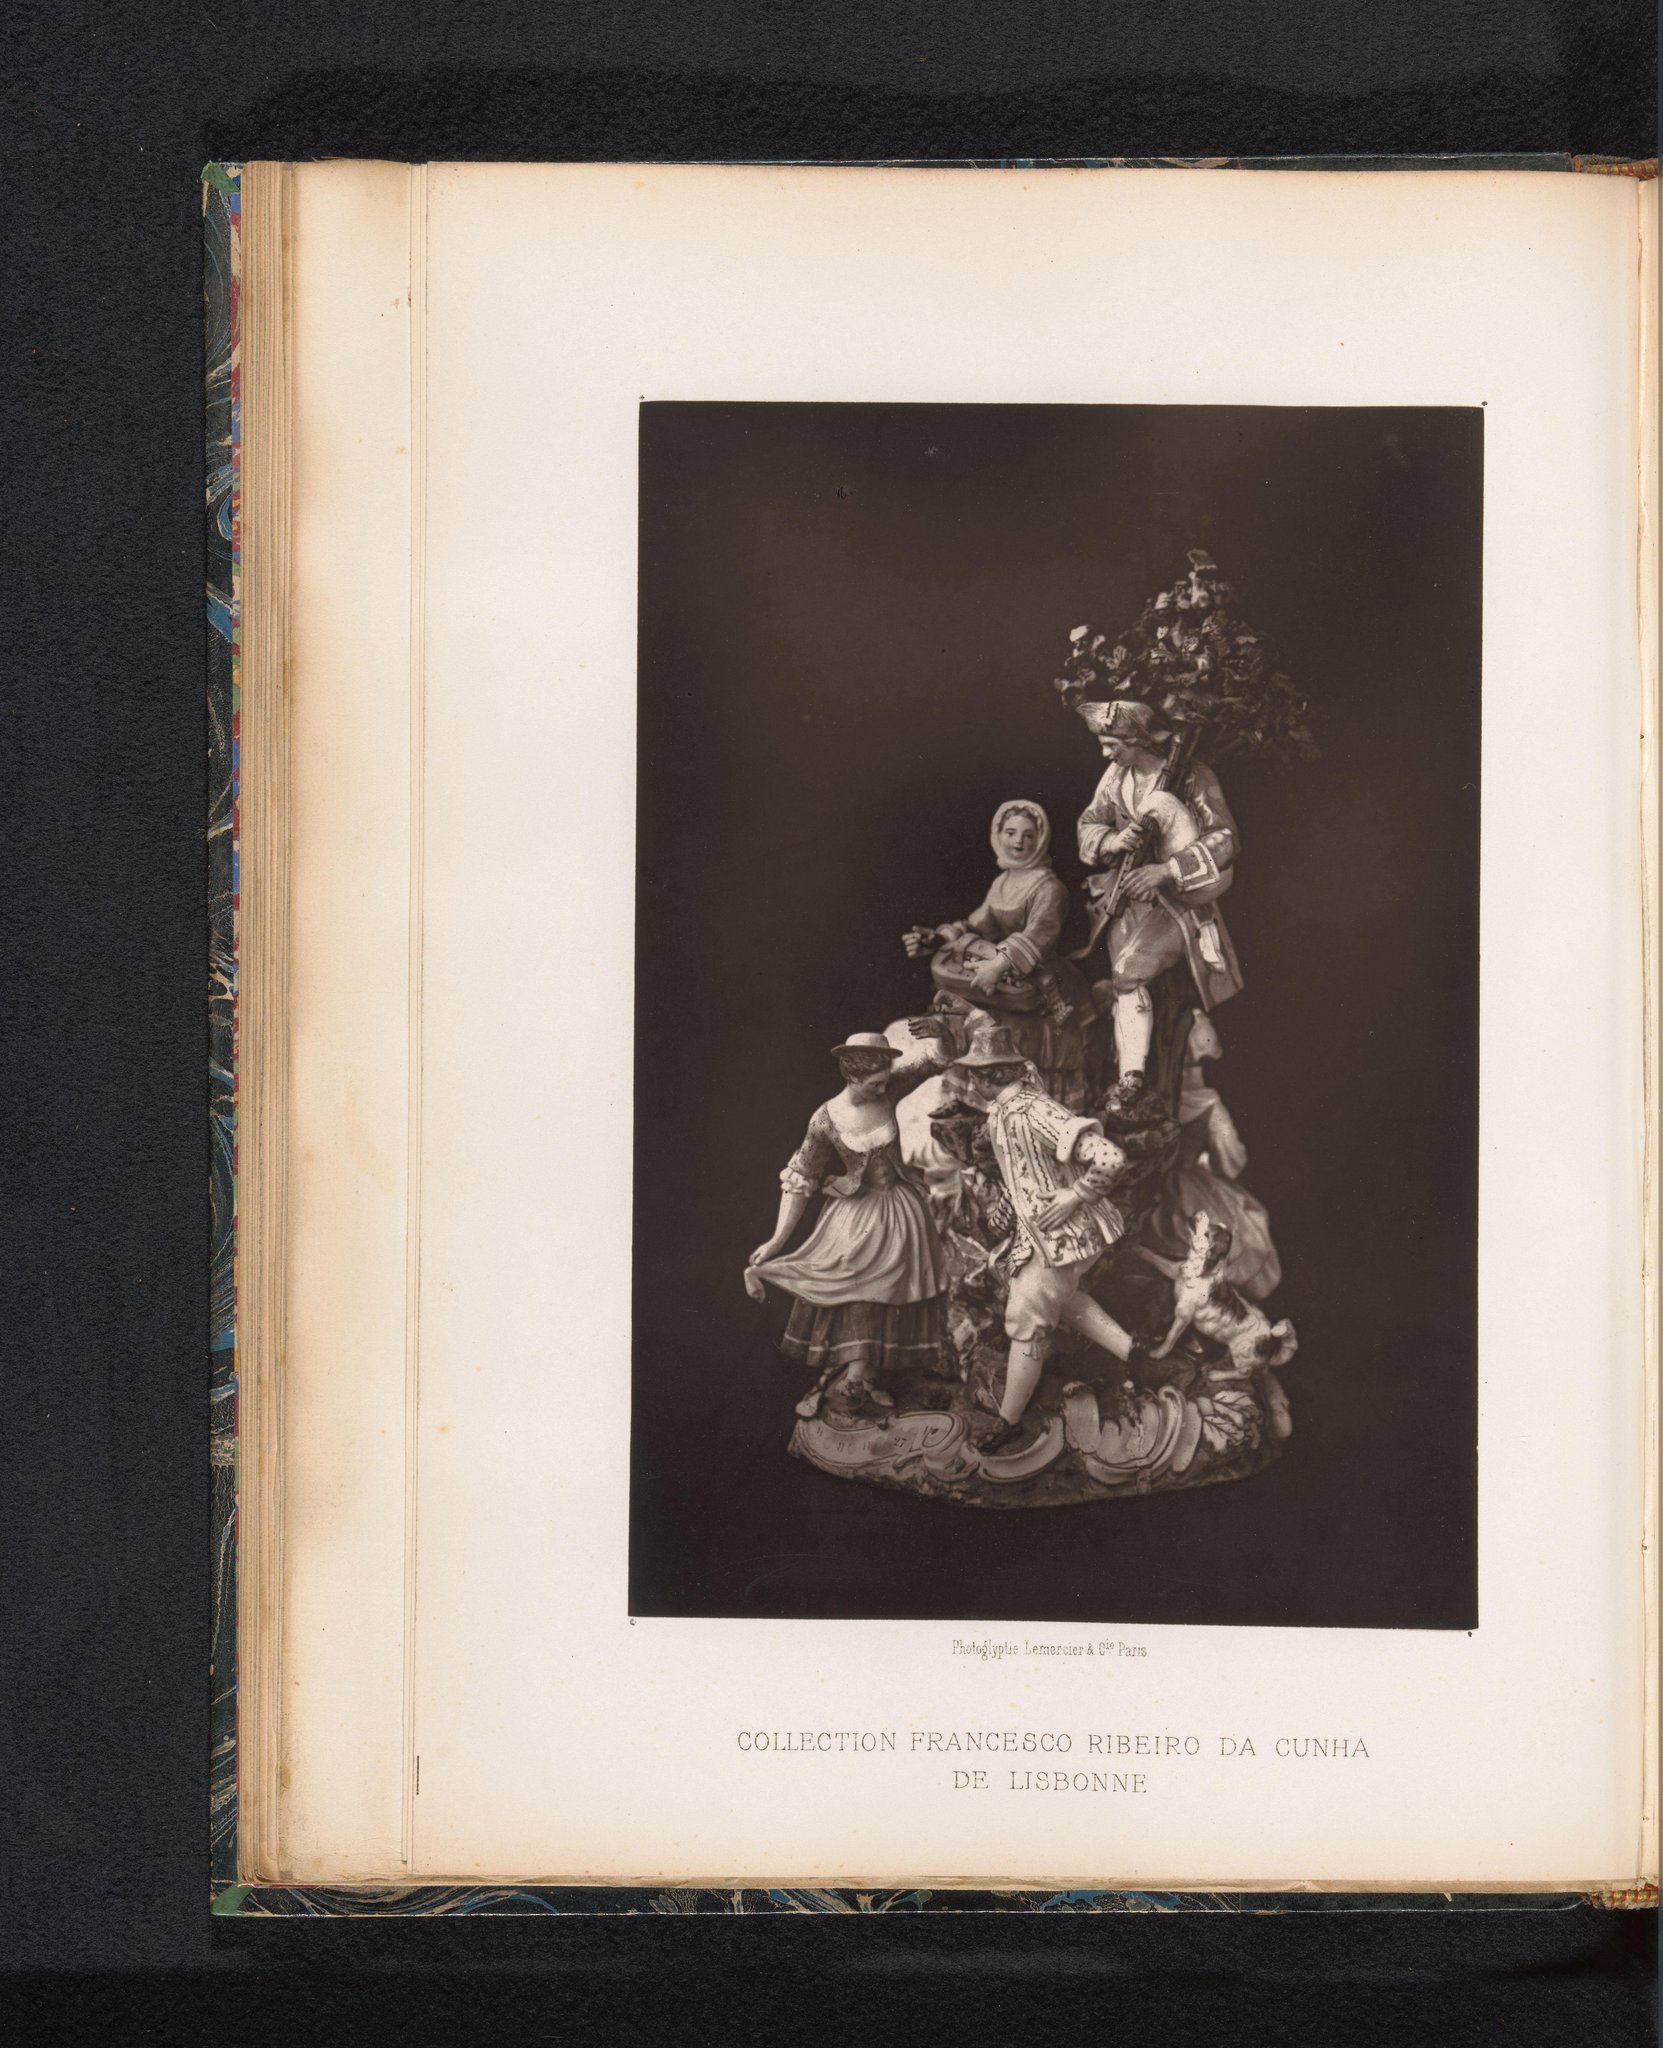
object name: page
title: Beeldengroep met zes figuren en een hond op een rots in Meissen porselein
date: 1879-1884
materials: paper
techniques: woodburytype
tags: sculpture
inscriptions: inscription: ‘Collection Francesco Riberio da Cunha de Lisbonne’